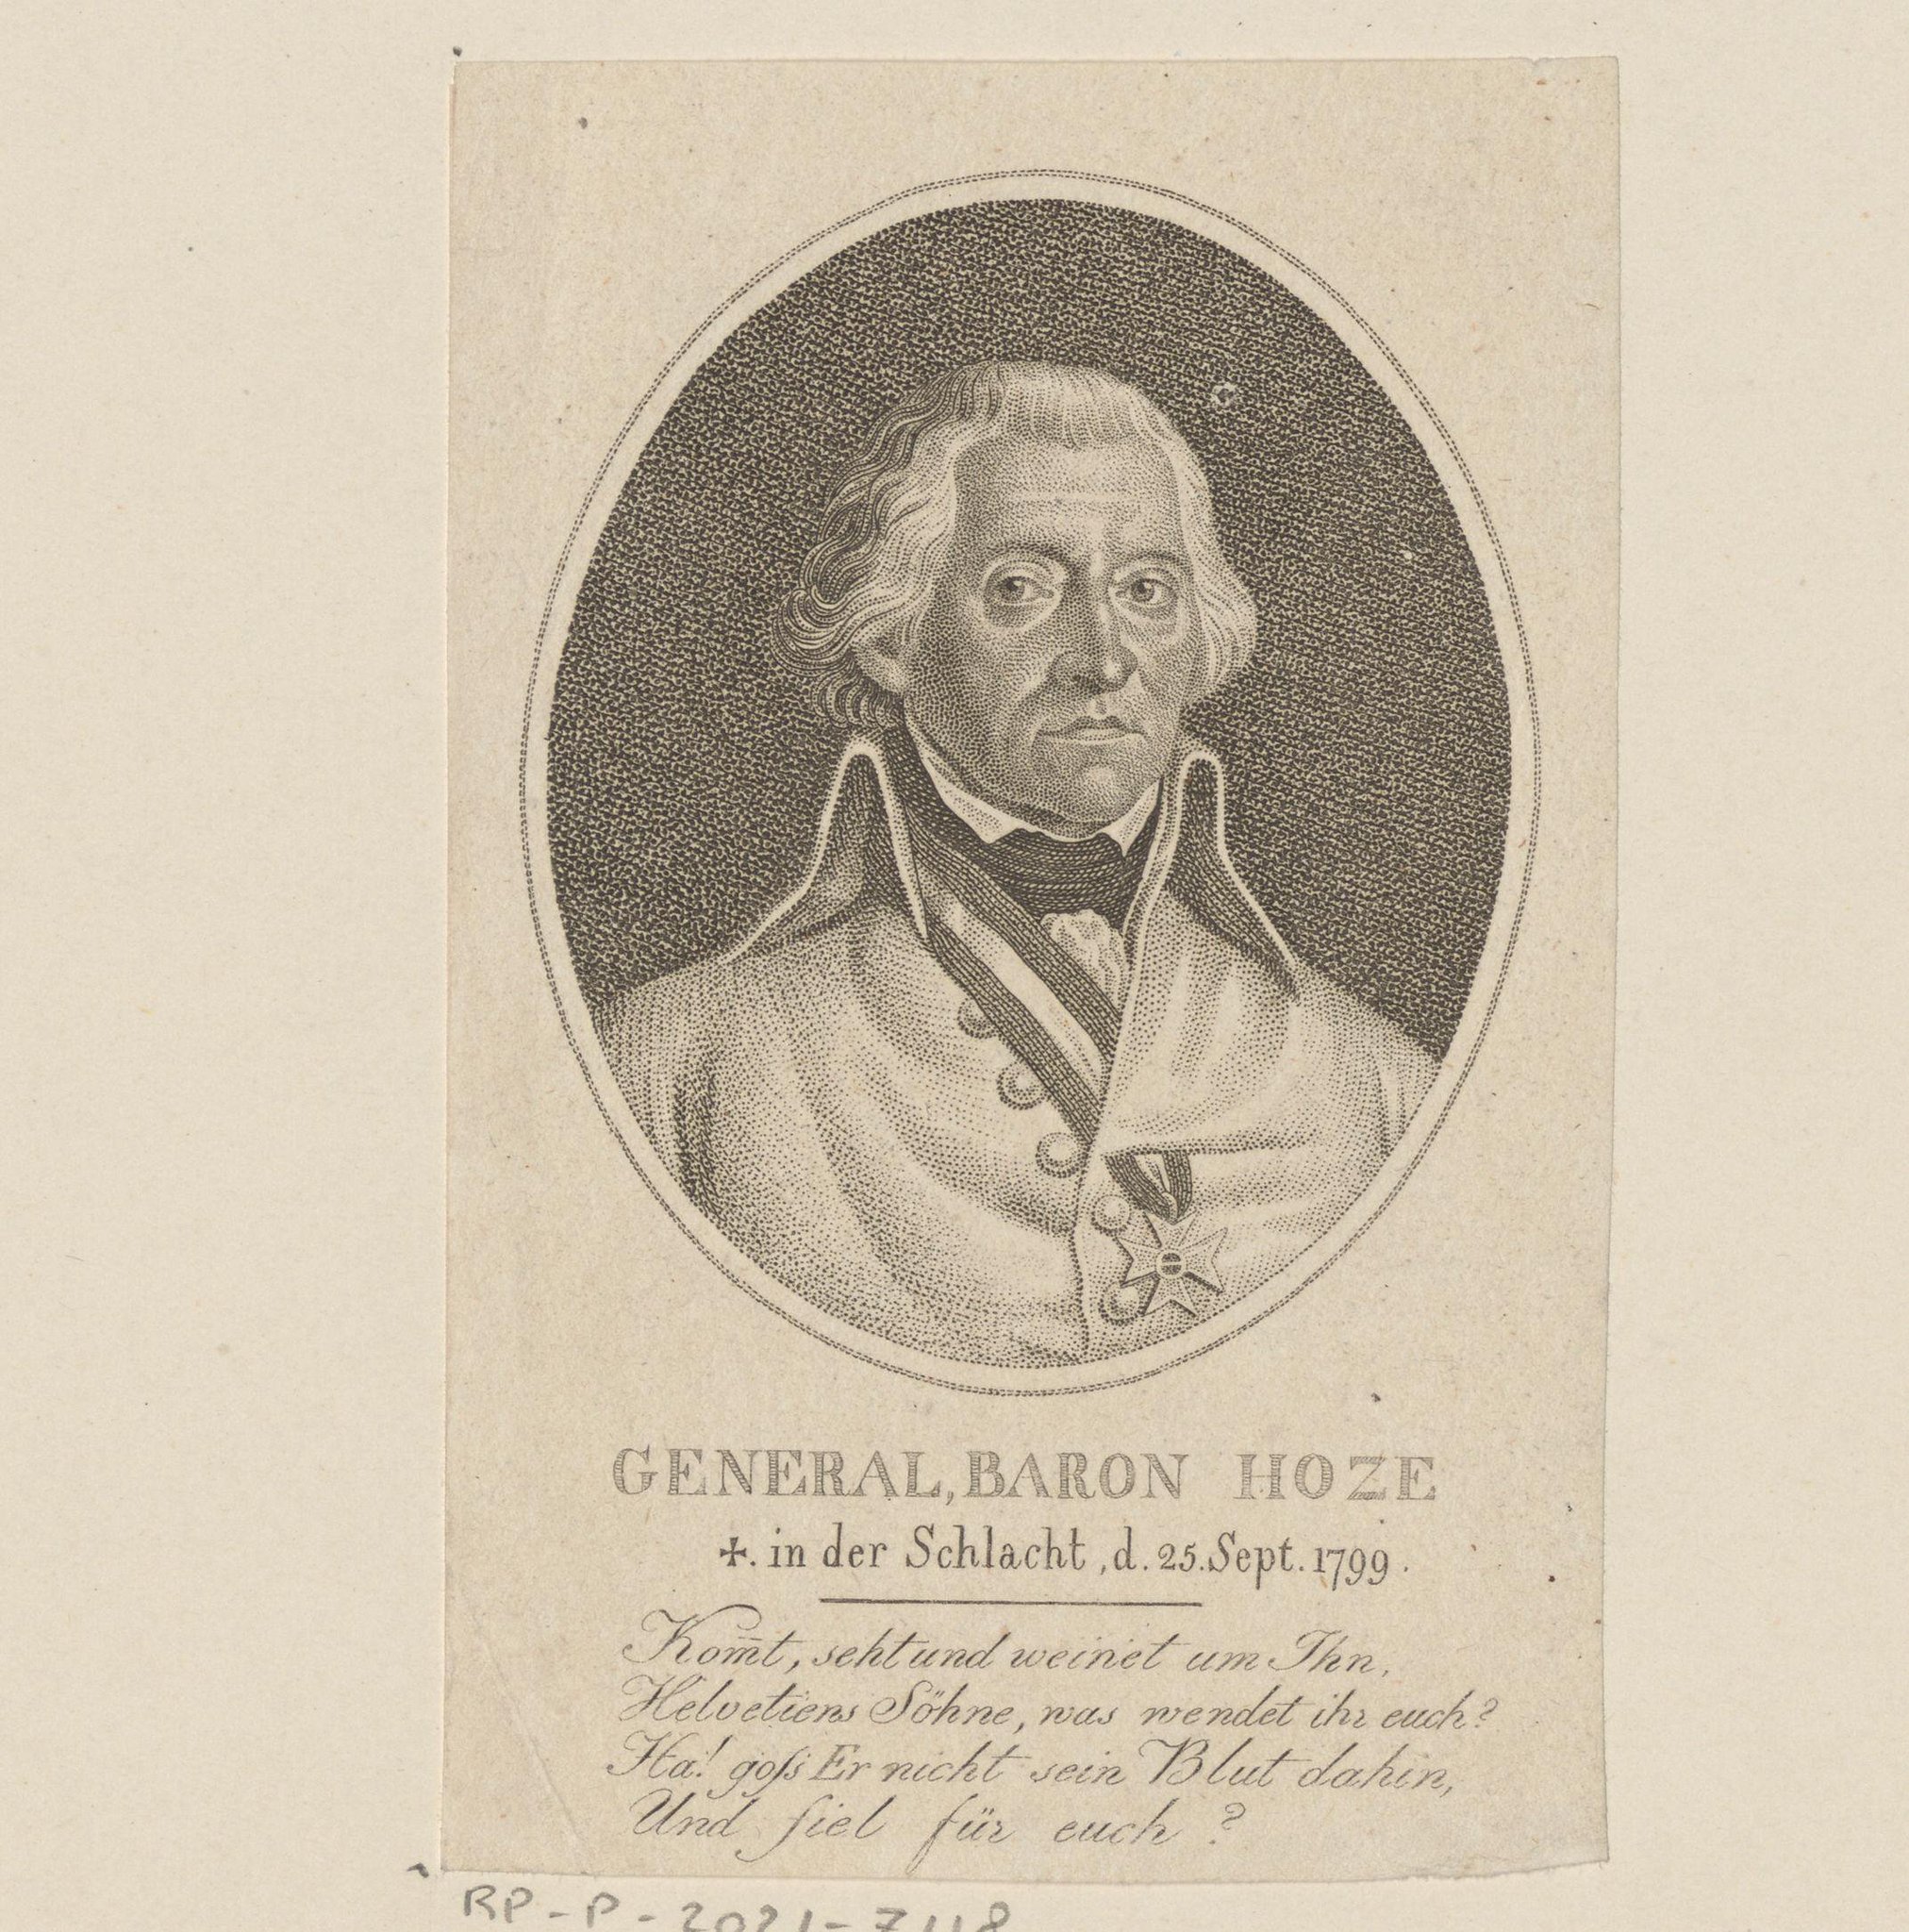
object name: print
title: Portret van Friedrich von Hotze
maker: Anonymous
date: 1799-1801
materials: paper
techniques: engraving, etching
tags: commander-in-chief, general, marshal, historical persons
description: Prent gebruikt in: Revolutions-Almanach von 1801. Göttingen: Dieterichsche Buchhandlung, 1801.